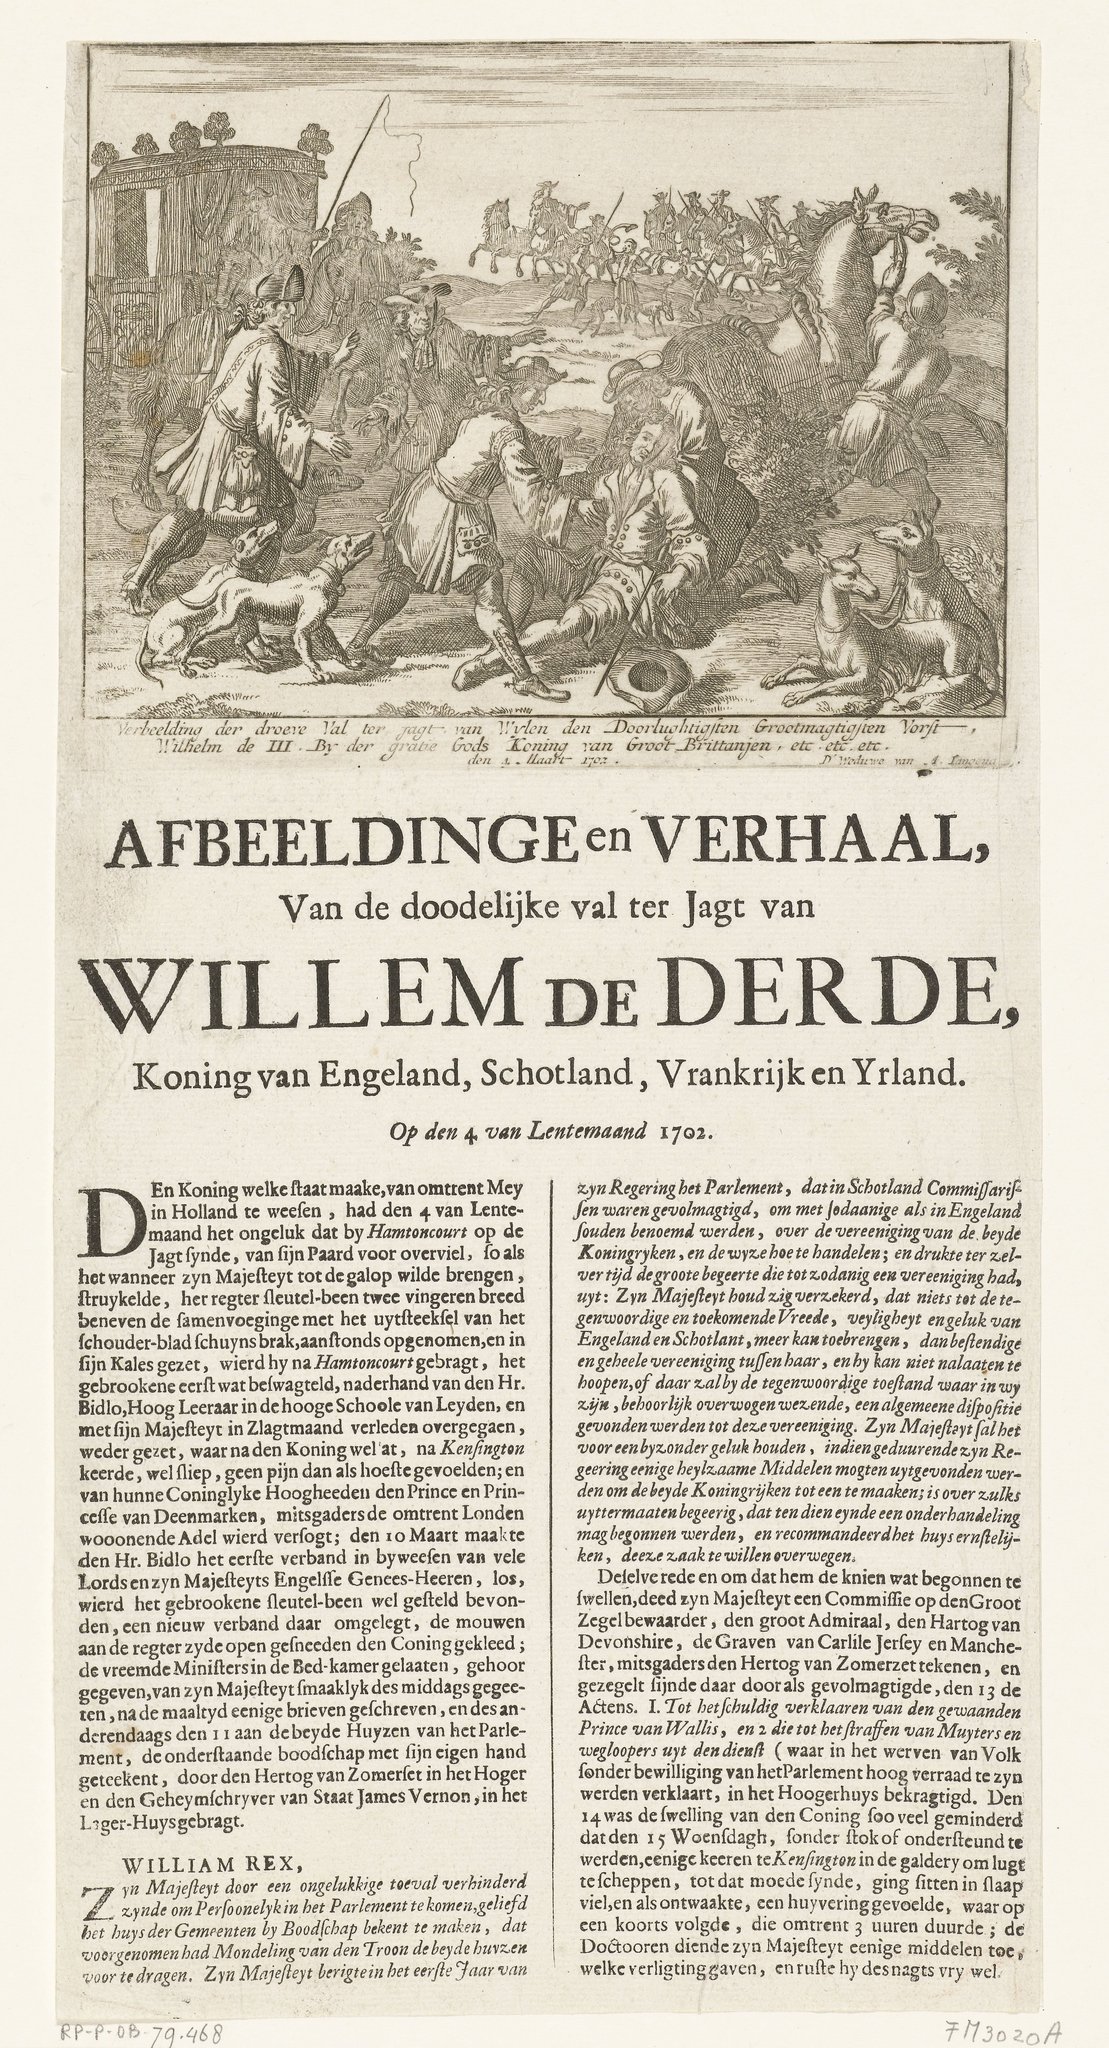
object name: print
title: De dodelijke val van Willem III tijdens een jachtpartij, 1702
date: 1702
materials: paper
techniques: etching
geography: northern netherlands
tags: the hague, william iii (prince of orange and king of england, scotland, and ireland), hunting accidents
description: De dodelijke val van koning Willem III tijdens een jachtpartij, 4 maart 1702. De koning zittend op de grond wordt door omstanders overeind geholpen, achter de koning zijn paard. In het onderschrift twee regels tekst. Op het blad onder de plaat een tekst in twee kolommen.